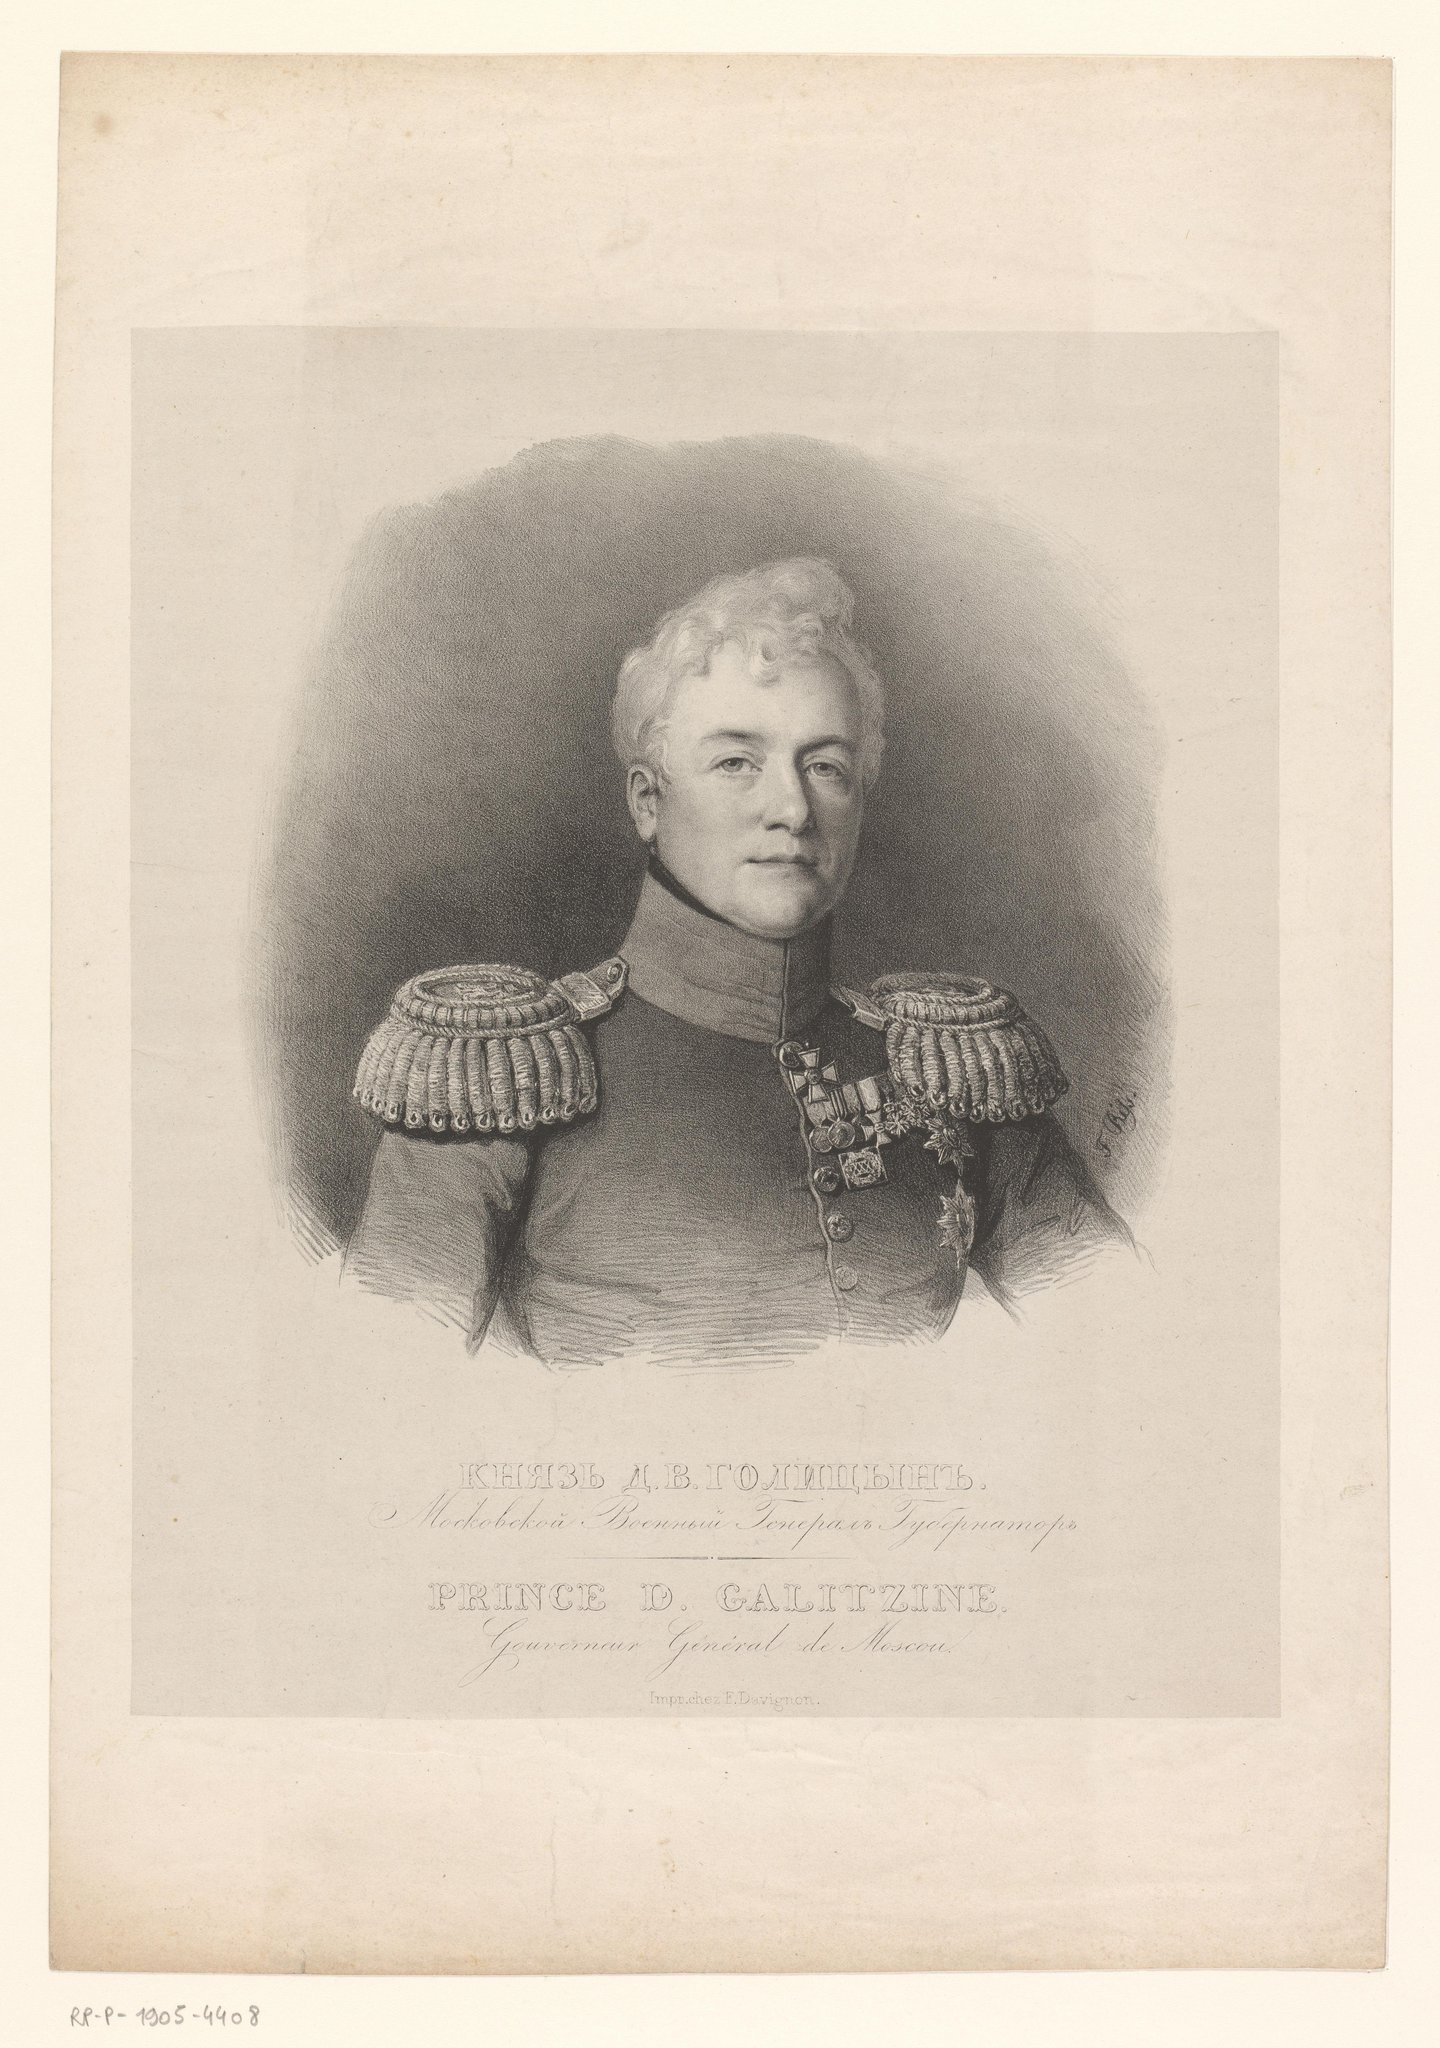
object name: print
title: Portret van Dmitry Golitsyn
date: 1830-1870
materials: paper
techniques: lithograph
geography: eastern europe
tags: adult man, historical persons, (military) uniforms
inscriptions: collector's mark: Lugt 2228, mark: ‘[F. Rifs]’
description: Onderschrift in het Cyrillisch en Frans.